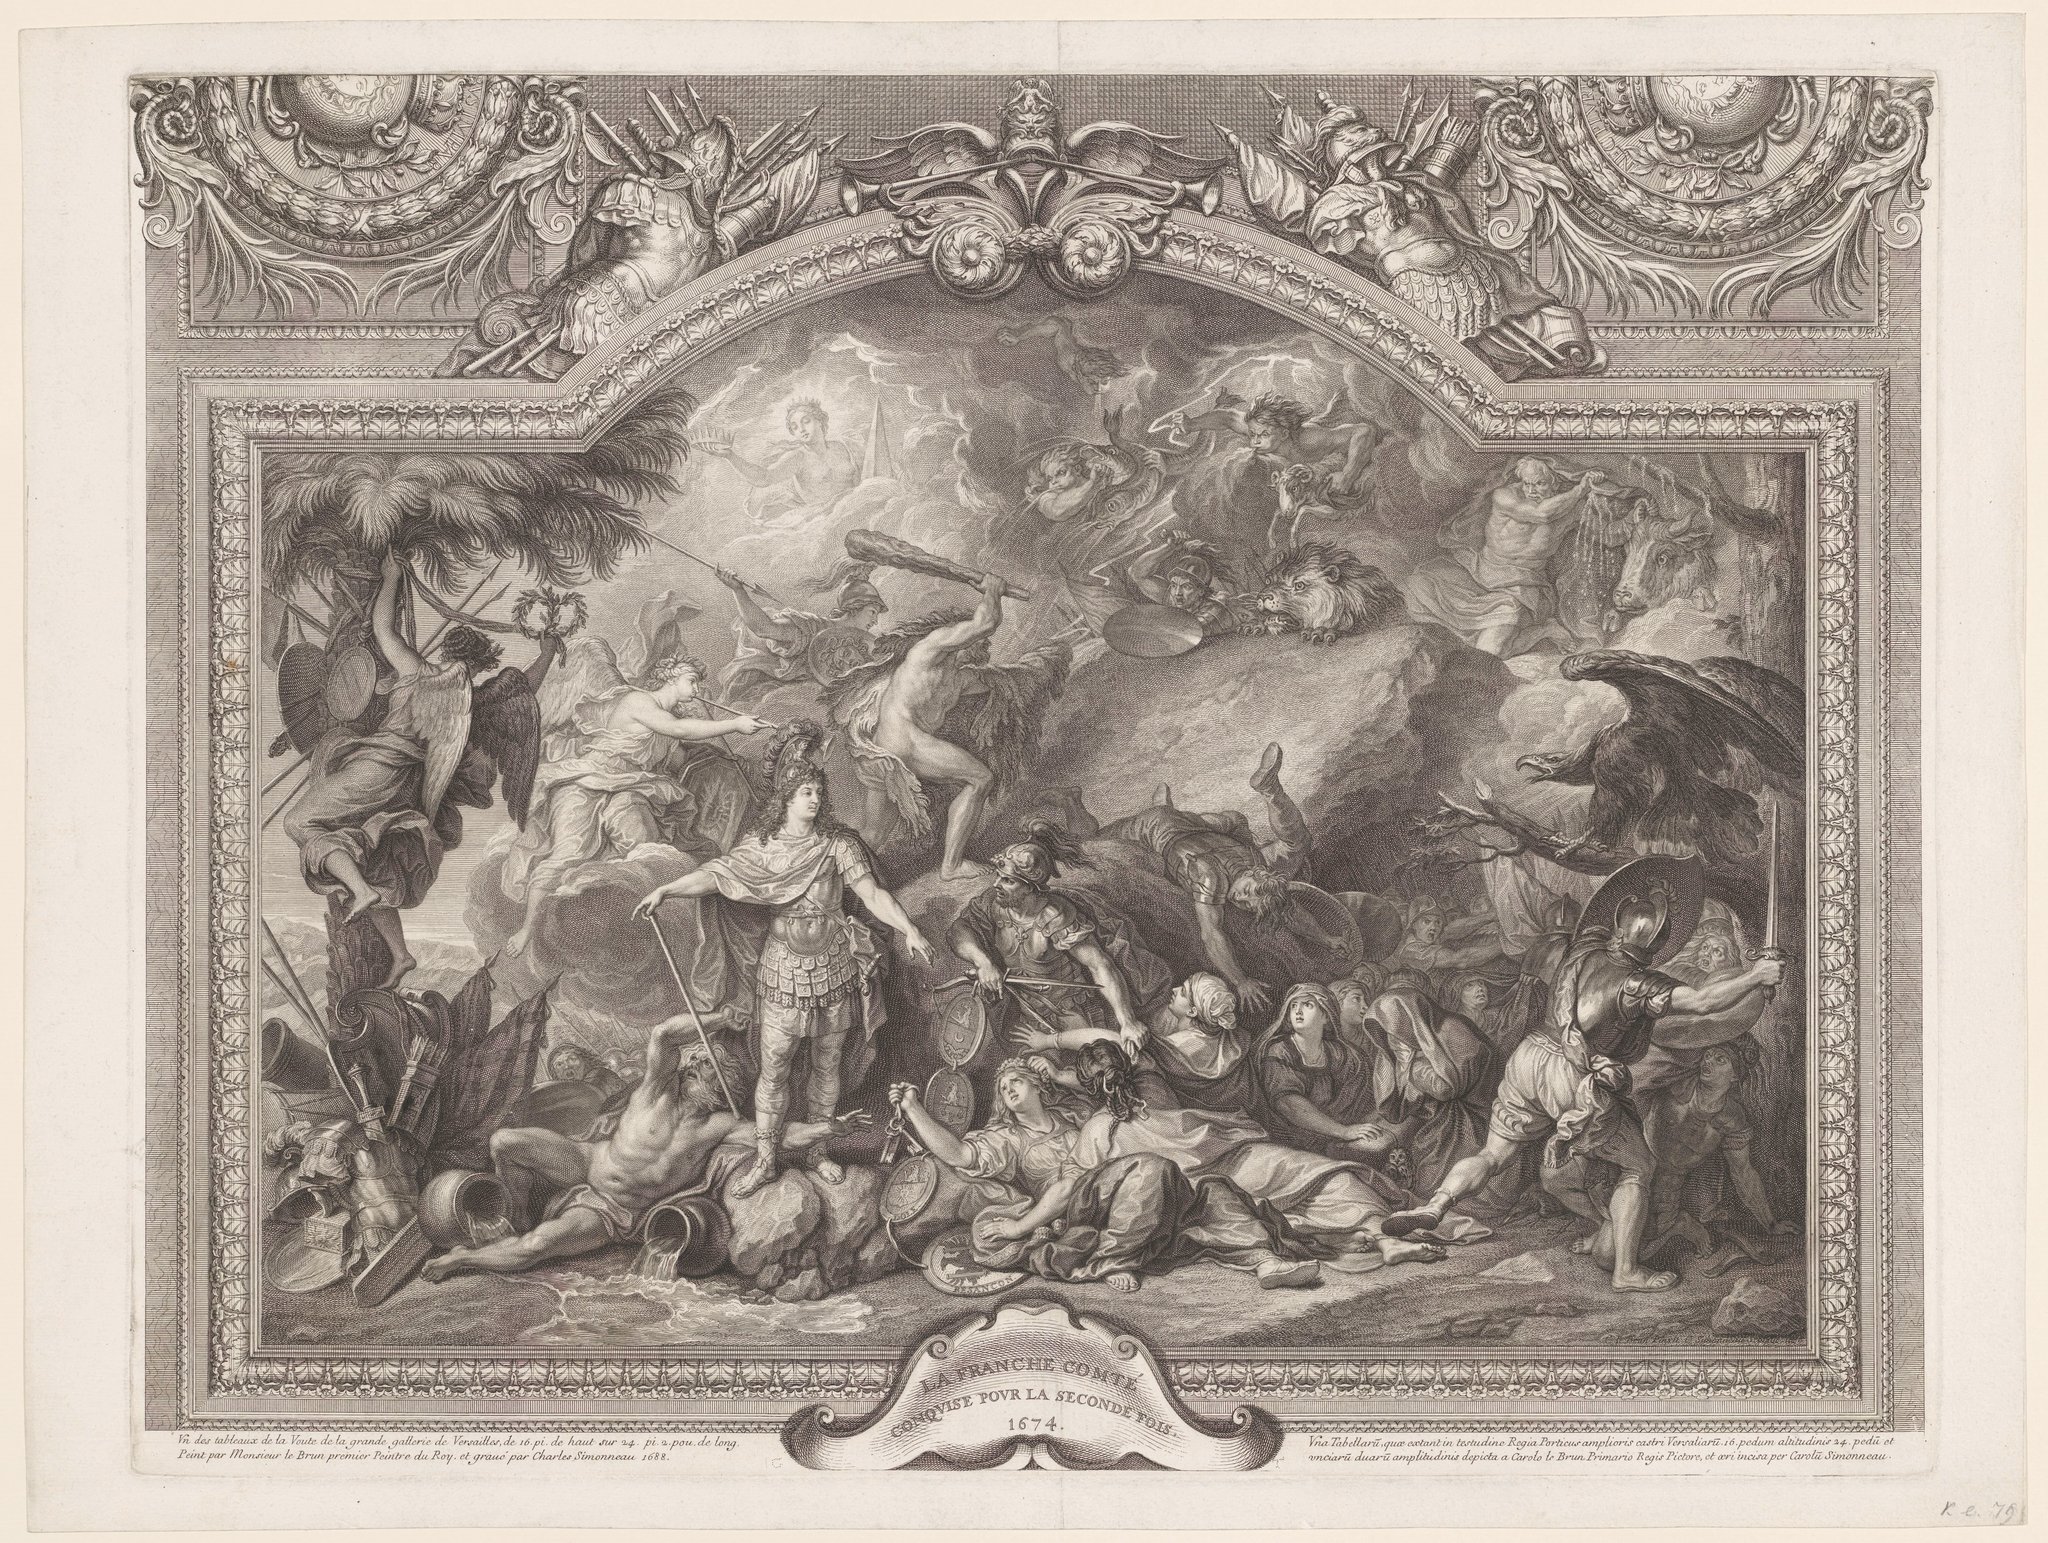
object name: print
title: La Franche Comté conquise pour la seconde fois 1674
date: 1688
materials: paper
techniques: engraving, etching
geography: france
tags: lodewijk xiv (koning van frankrijk), (story of) hercules (heracles), (story of) mars (ares), (story of) minerva (pallas, athena), warfare; military affairs, astrological signs and symbols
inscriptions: collector's mark: Lugt 2228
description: Aan de voeten van Lodewijk XIV liggen de personificaties van de Franche-Comté en steden in dat gebied. Naast Lodewijk een riviergod die de rivier de Doubs verpersoonlijkt. Achter de koning bestormen Hercules en Minerva een rots, symbool van het fort van Besançon, met op de top de Spaanse leeuw. In de lucht zijn de sterrenbeelden ten tijde van het beleg te zien (Vissen, Ram en Stier). Helemaal rechts zit de Duitse adelaar gefrustreerd in een boom.